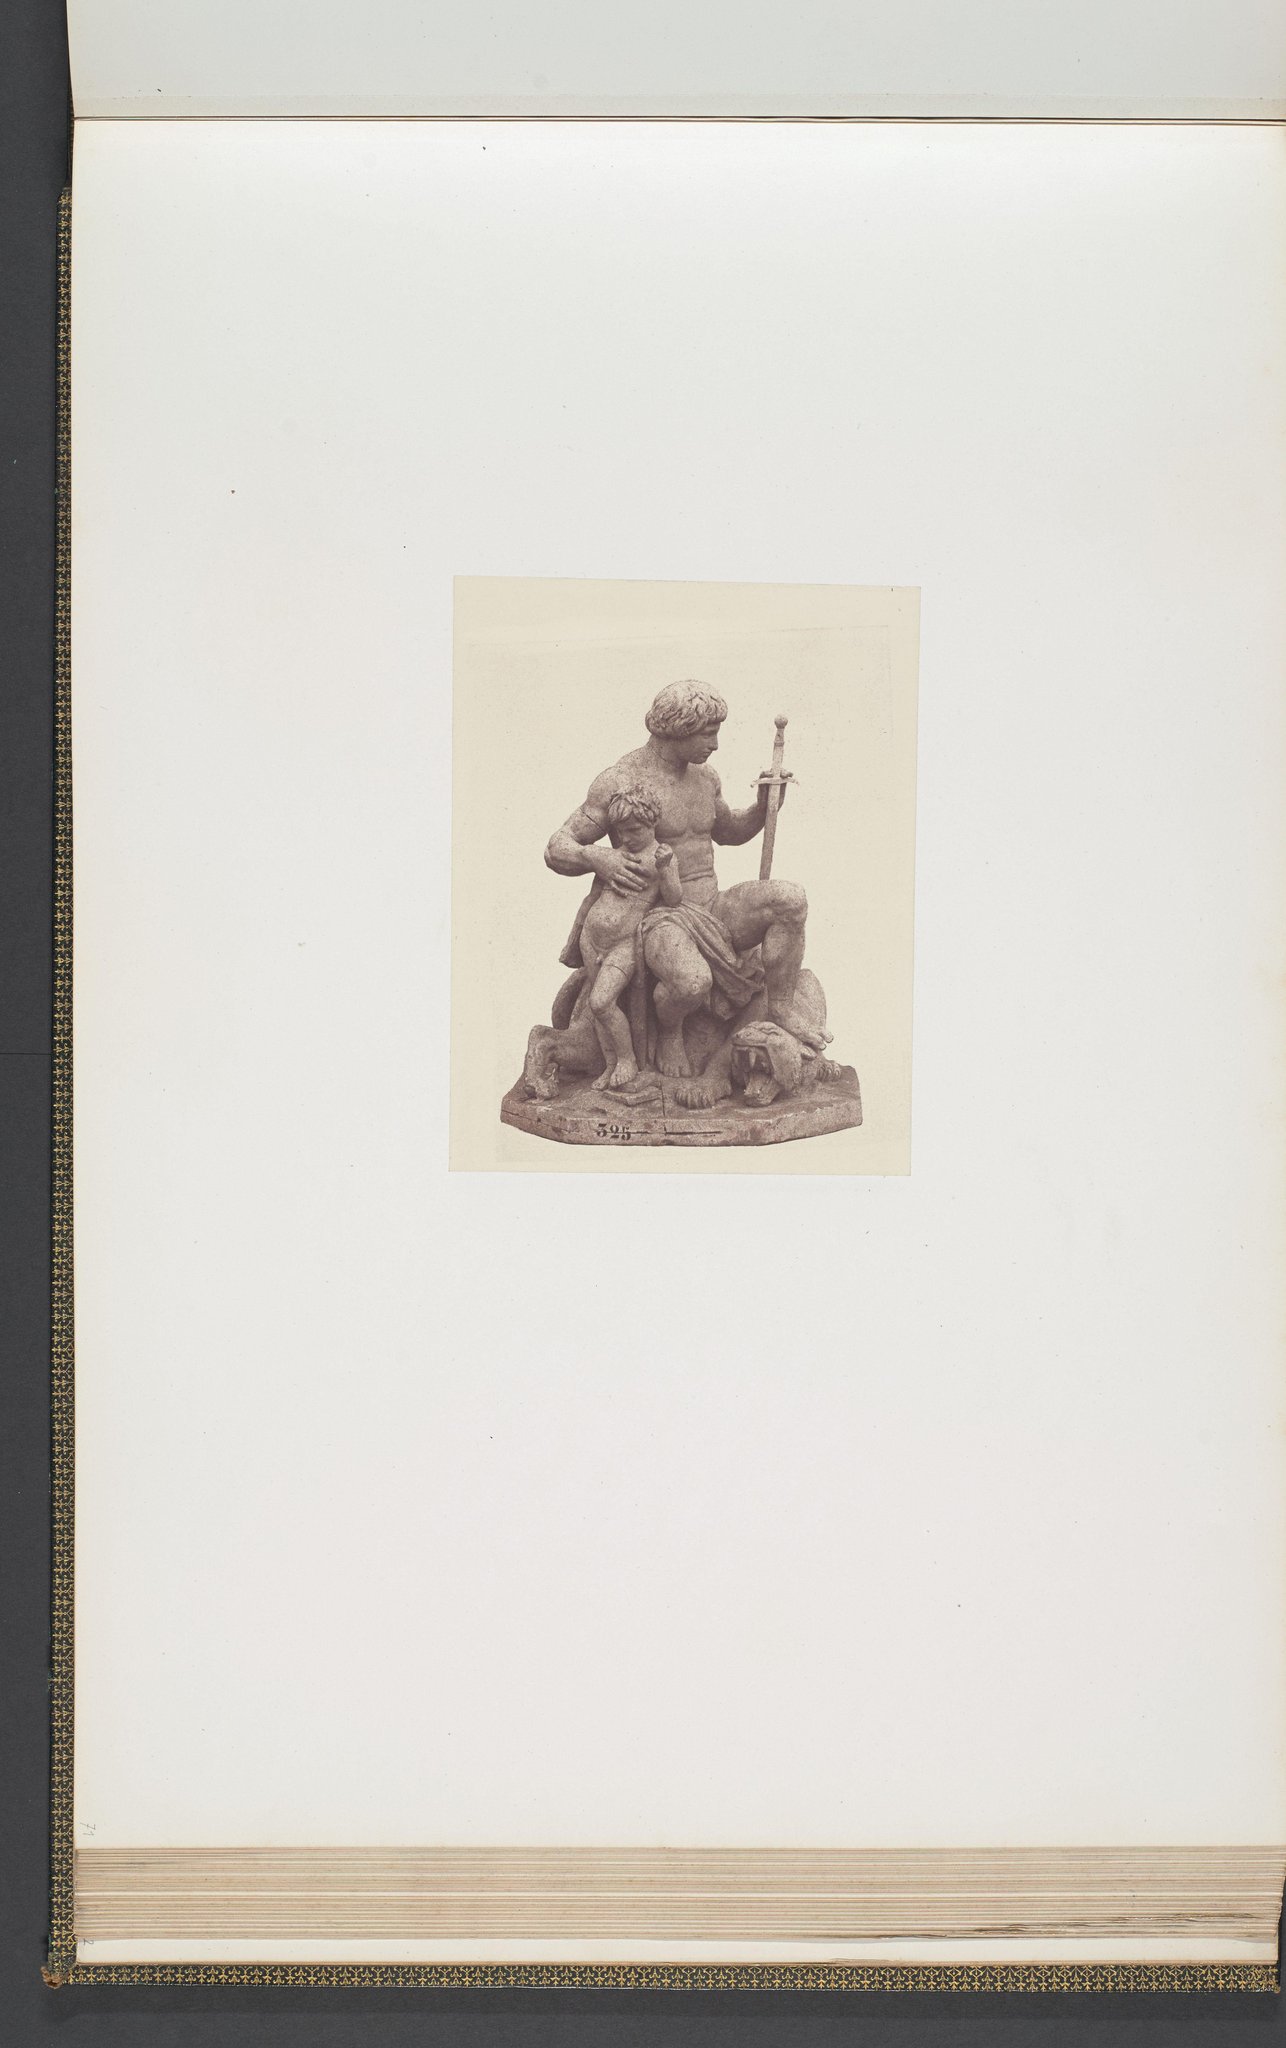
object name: album leaf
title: Gipsmodel voor beeldhouwwerk op het Palais du Louvre: "L'Ordre" door Antoine-Louis Barye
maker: édouard denis baldus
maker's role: fotograaf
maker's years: 1813-1889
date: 1855-1857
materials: paper, photographic support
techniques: salted paper print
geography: paris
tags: piece of sculpture, reproduction of a piece of sculpture, permanent exhibition, museum, paris, tuileries palace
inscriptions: number: ‘325’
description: Onderdeel van Réunion des Tuileries au Louvre 1852-1857, album 2.